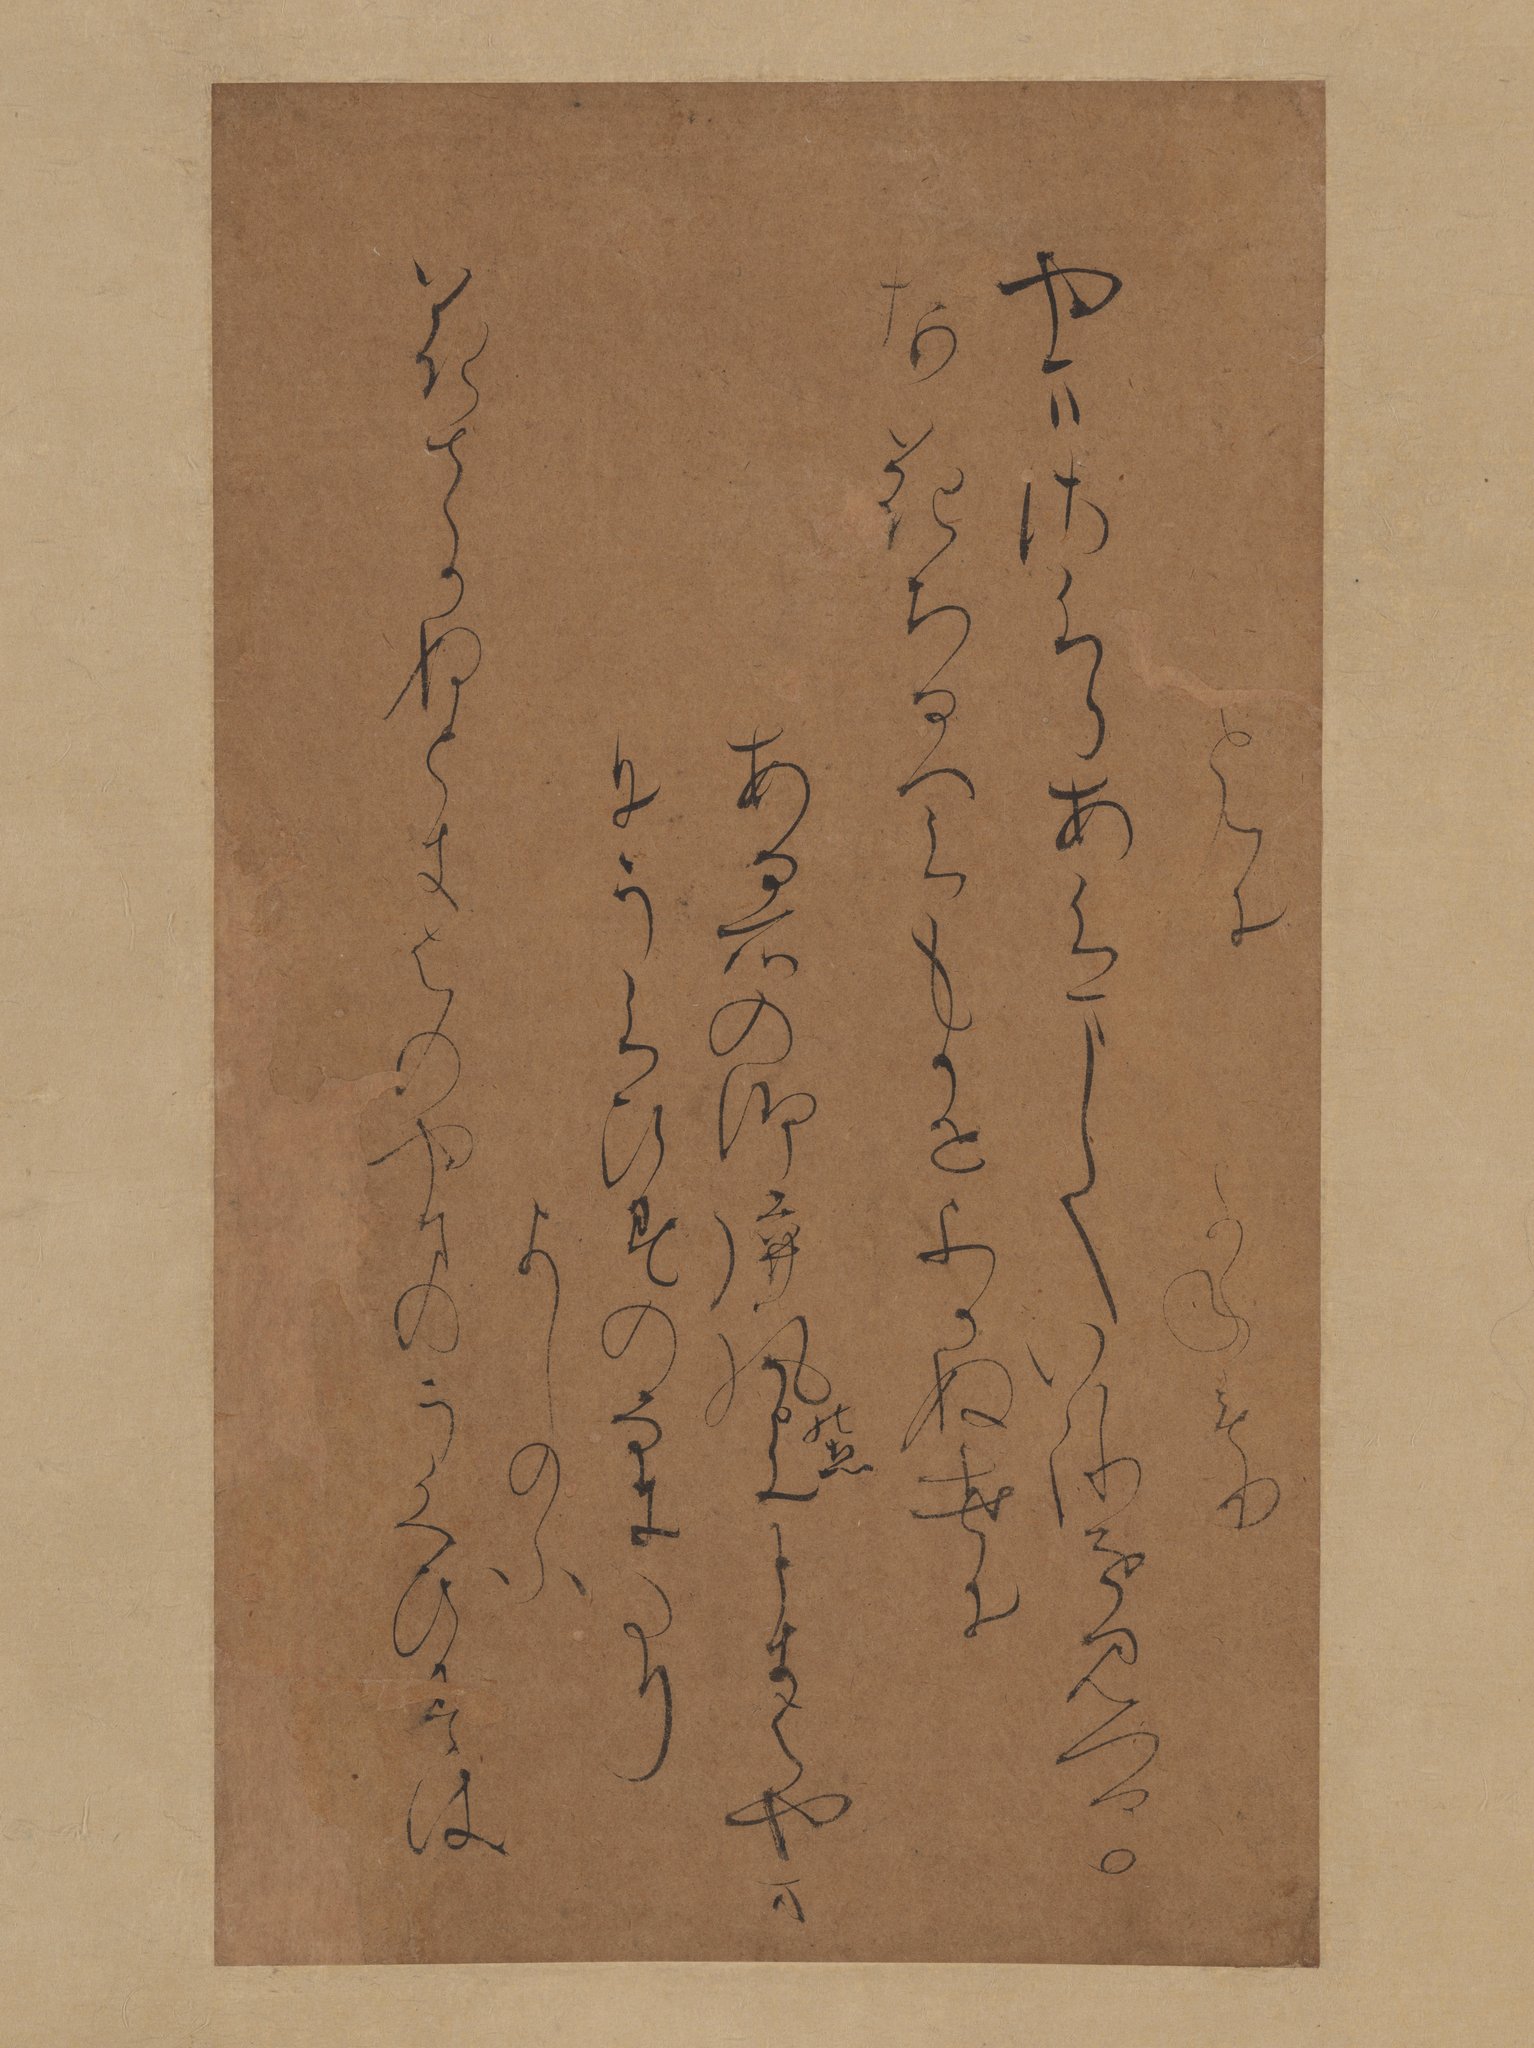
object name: hanging scroll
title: Poem about Cherry Blossoms from Collection of Elegant Flowers (Reikashū), one of the Scented-Paper Fragments (Kōshi-gire)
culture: japanese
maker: kodai no kimi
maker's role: artist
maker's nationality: japanese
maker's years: 967-1033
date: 1067-1100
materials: ink, paper